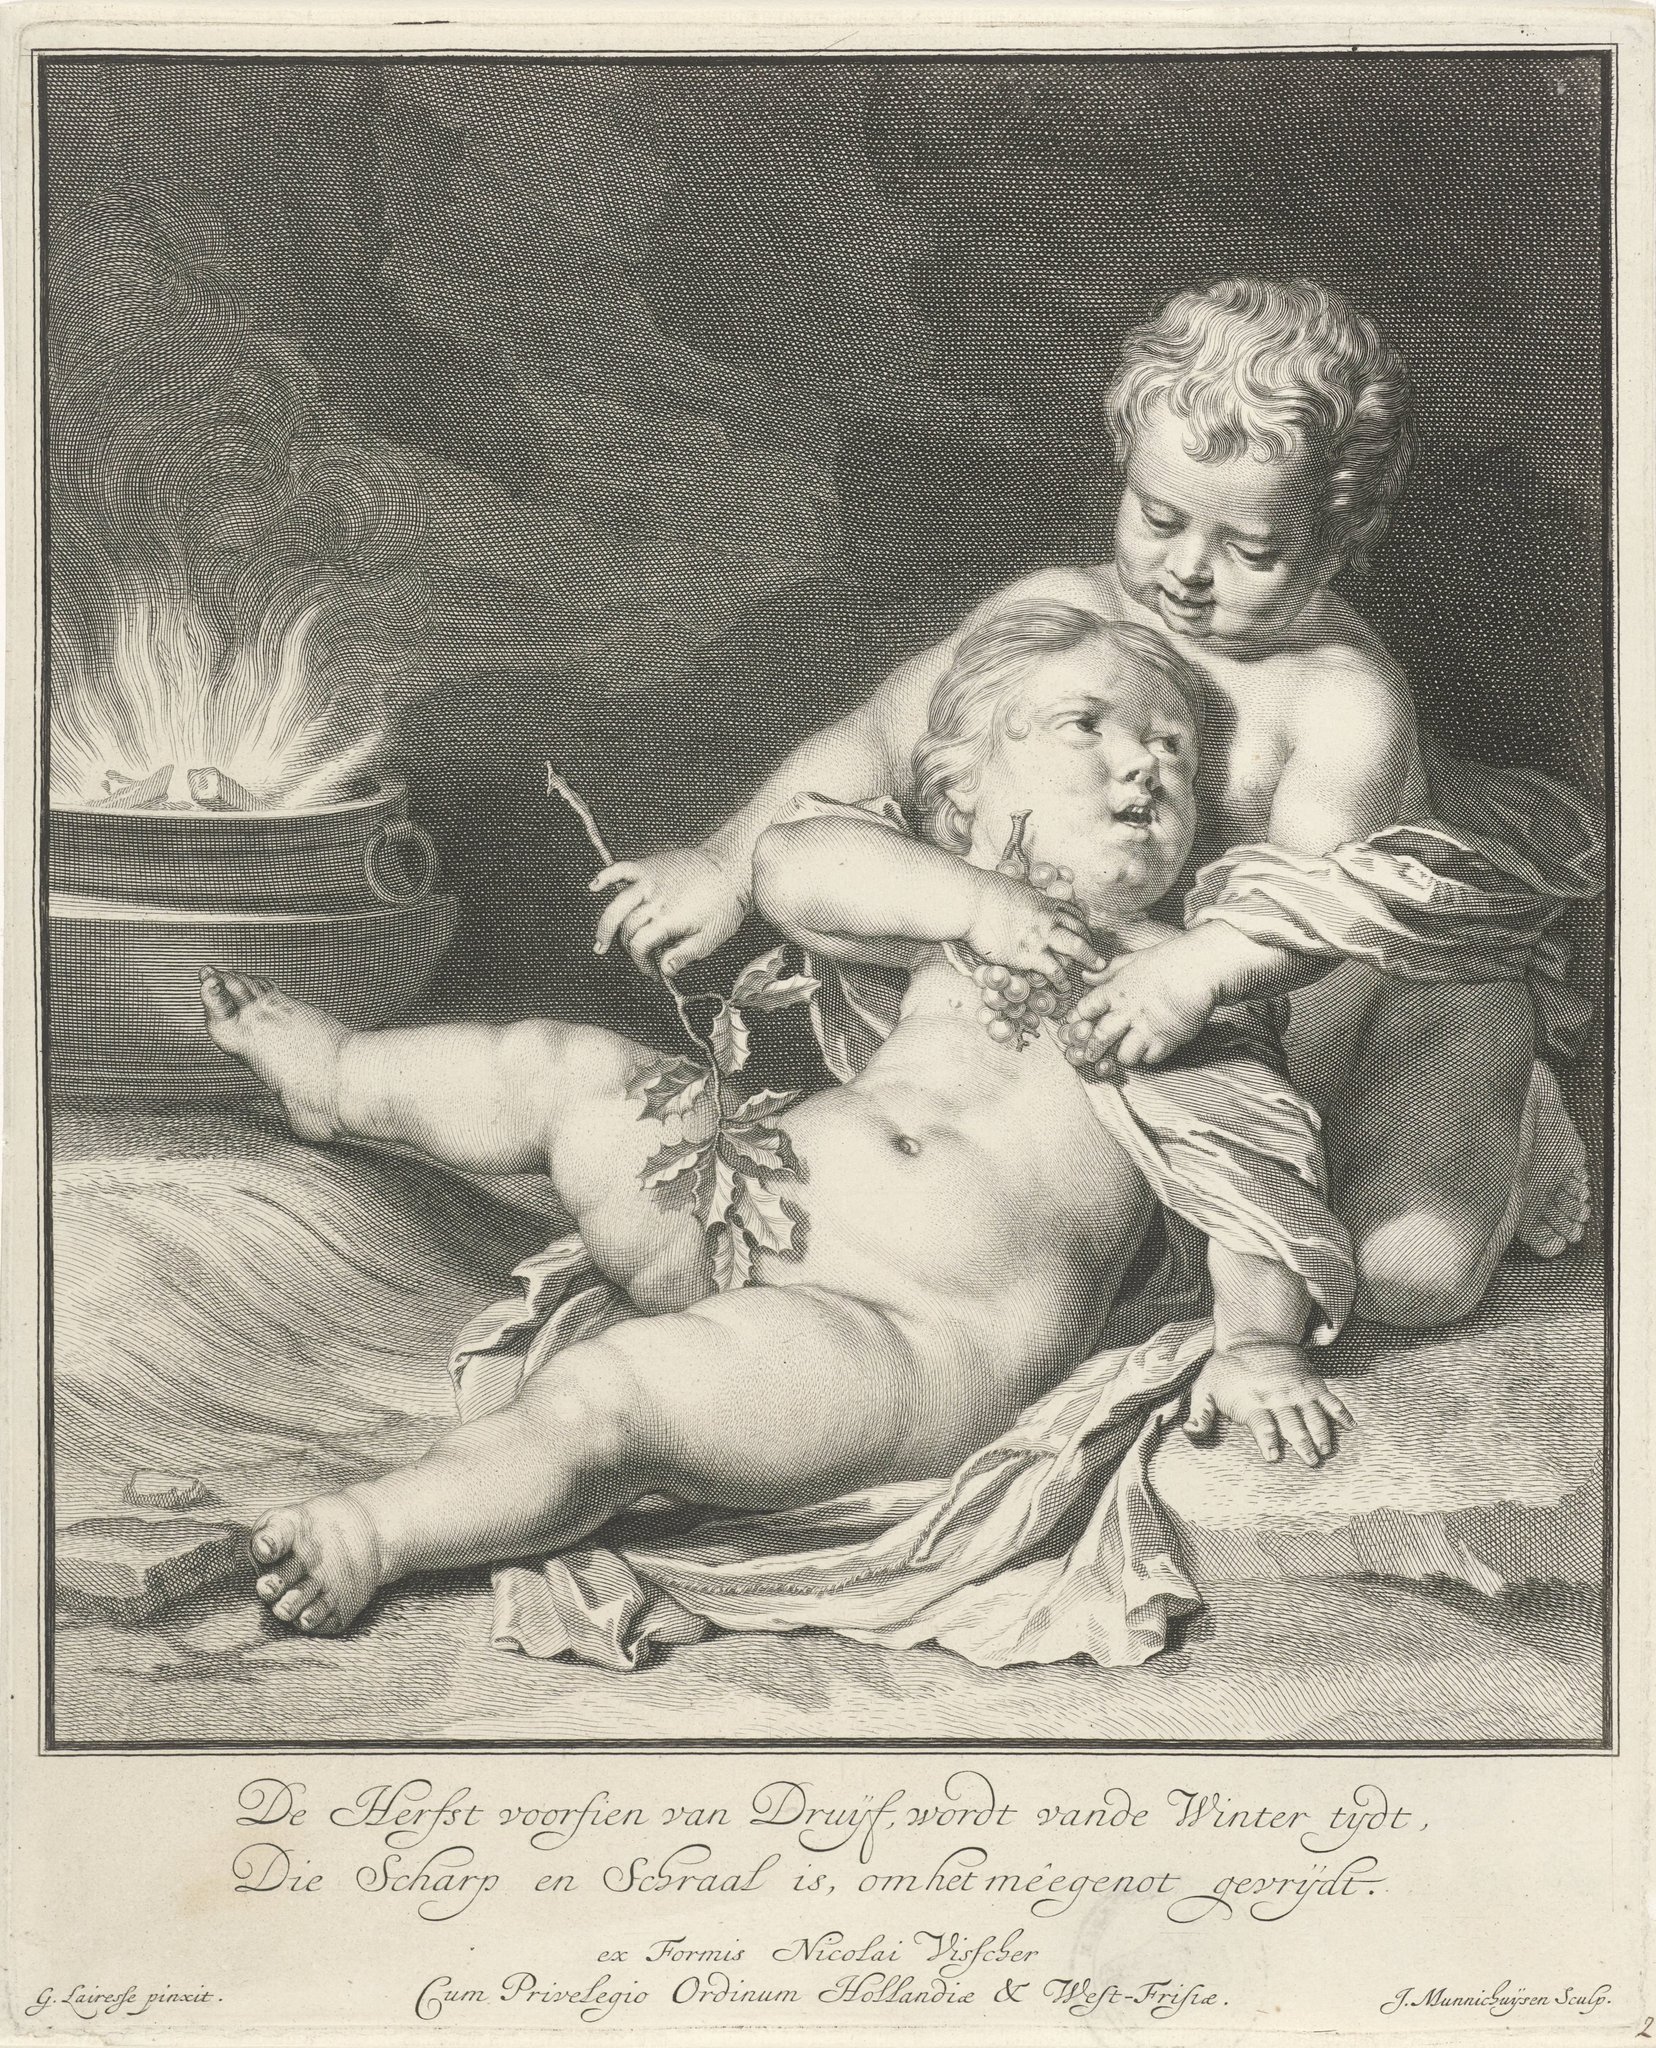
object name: print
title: Twee kinderen met druiventros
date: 1664-1721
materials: paper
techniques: engraving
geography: amsterdam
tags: children's bacchanal, warming oneself at a fire (or hearth, stove, fire-pan, brazier), cupids: 'amores', 'amoretti', 'putti', bunch of grapes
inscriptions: number: ‘2’, collector's mark: Lugt 11, collector's mark: Lugt 10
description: Twee naakte kinderen bij een vuurpot. Het ene kind probeert druiven van de druiventros van de ander te ontfutselen. Onder de voorstelling een tweeregelig vers in het Nederlands, waarin wordt aangegeven dat druiven in de wintertijd fel begeerd worden.